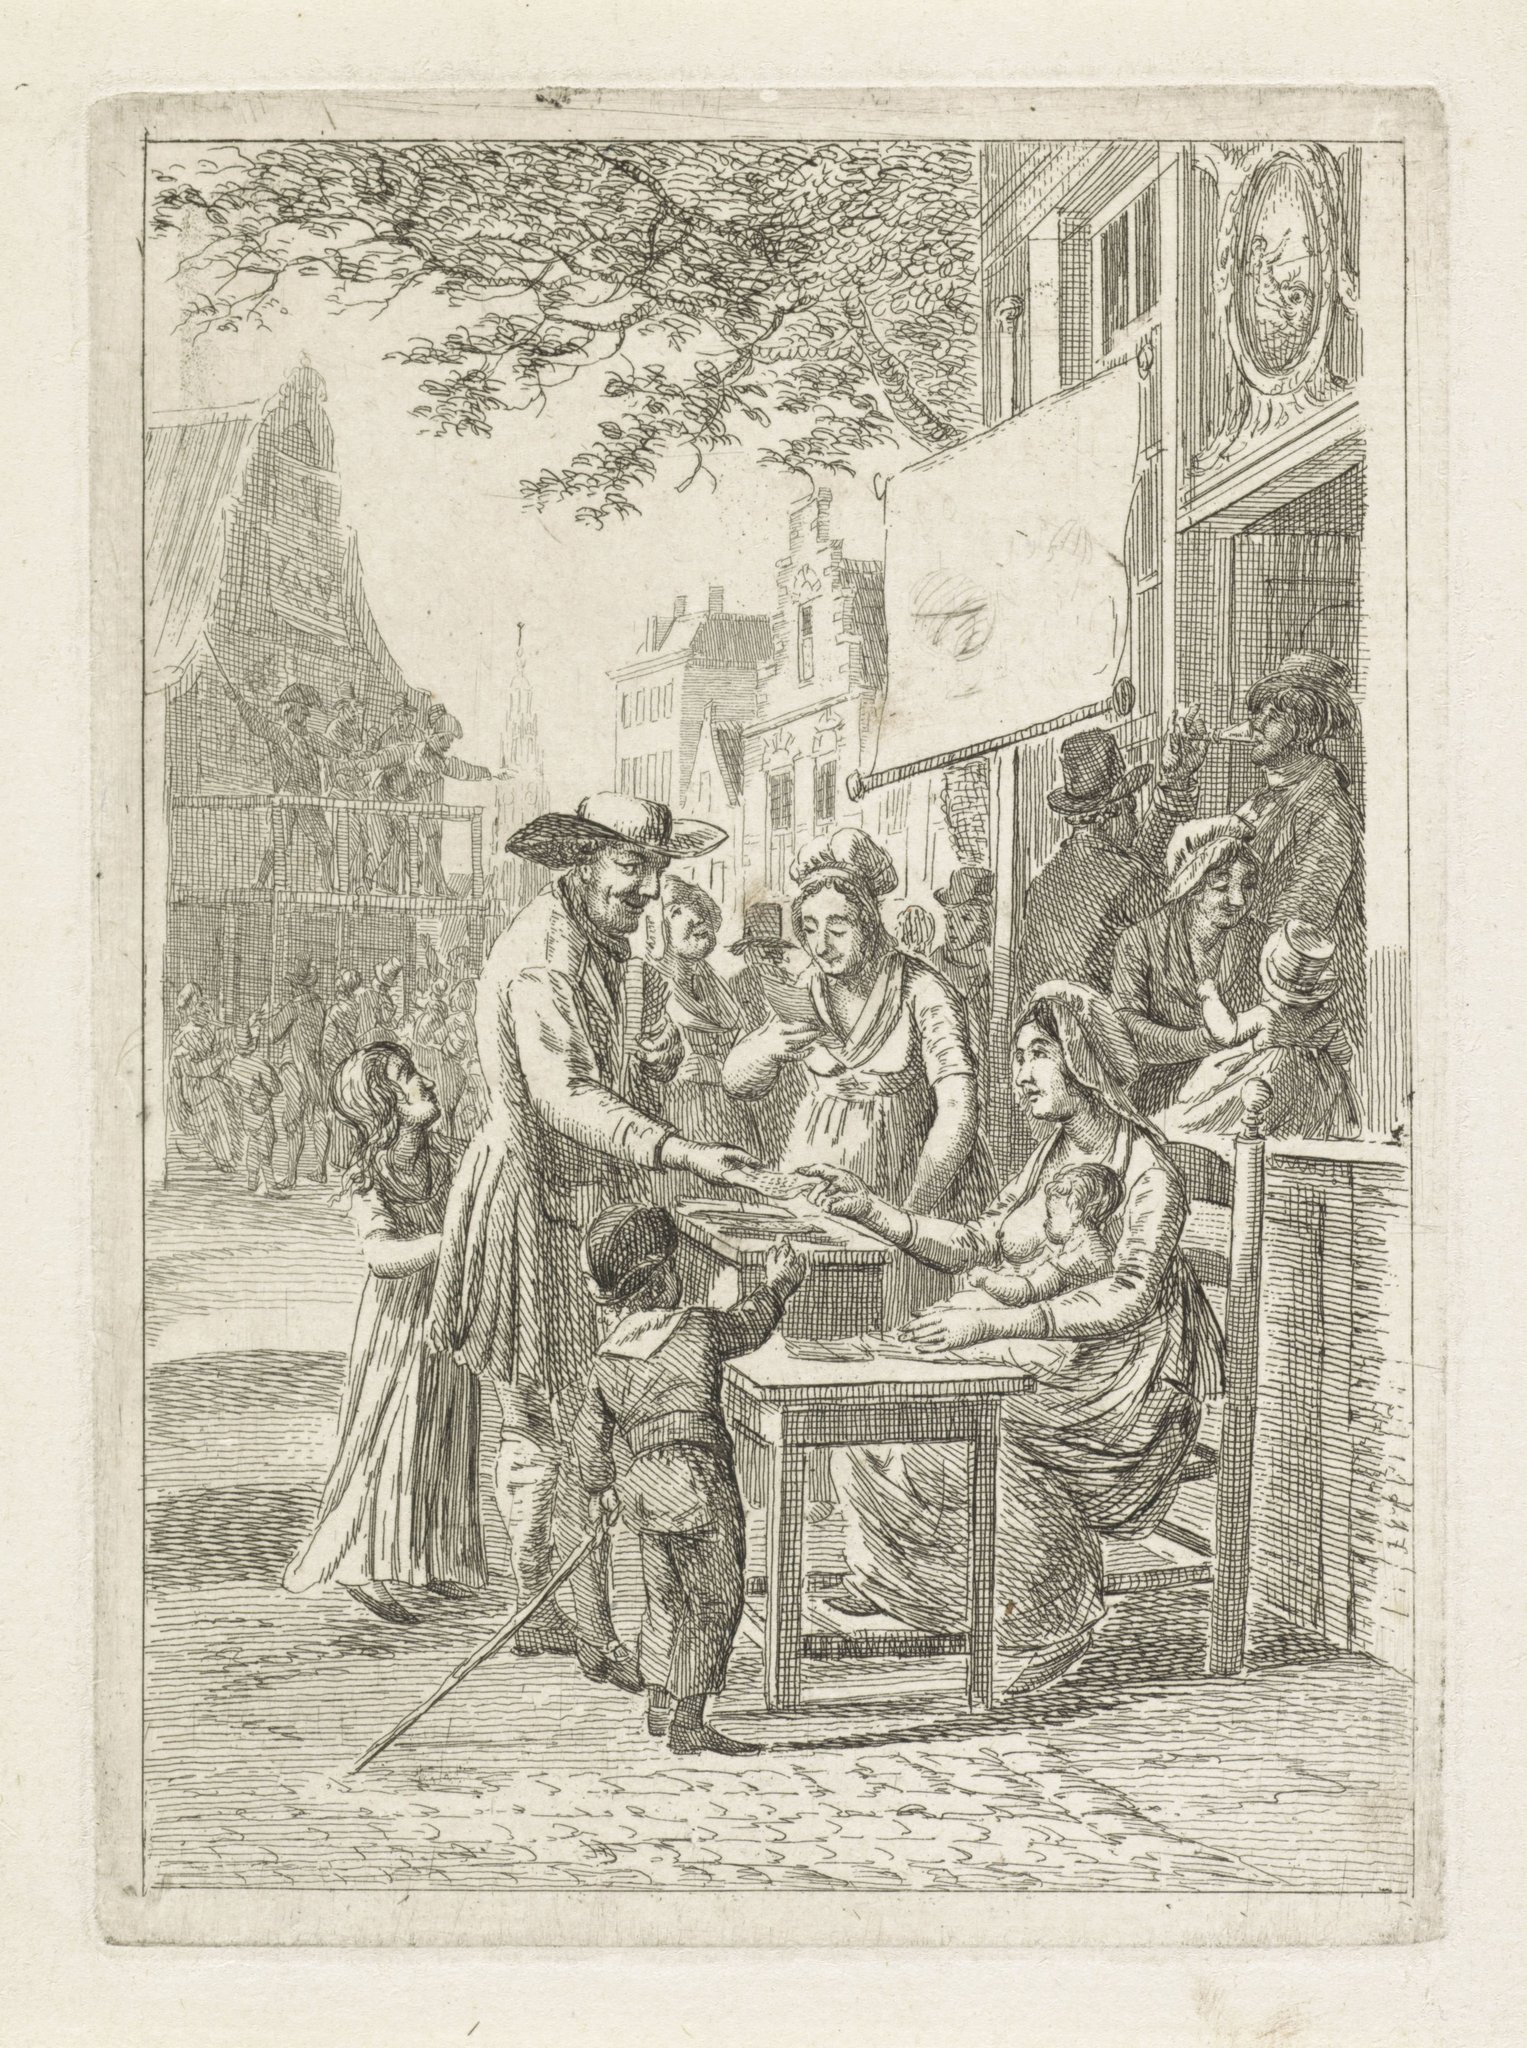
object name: print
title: Vrouw deelt horoscopen uit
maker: monogrammist ggw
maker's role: print maker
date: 1800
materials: paper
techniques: etching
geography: low countries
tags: horoscope, astrologer at work, village square, place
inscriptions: collector's mark: Lugt 2228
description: Rechts zit een vrouw voor een herberg met een kind op haar schoot. Ze geeft een horoscoop aan de man die voor haar staat. Naast haar staat een vrouw haar horoscoop te lezen. Op de achtergrond een dorpsplein met enkele figuren op een stellage.